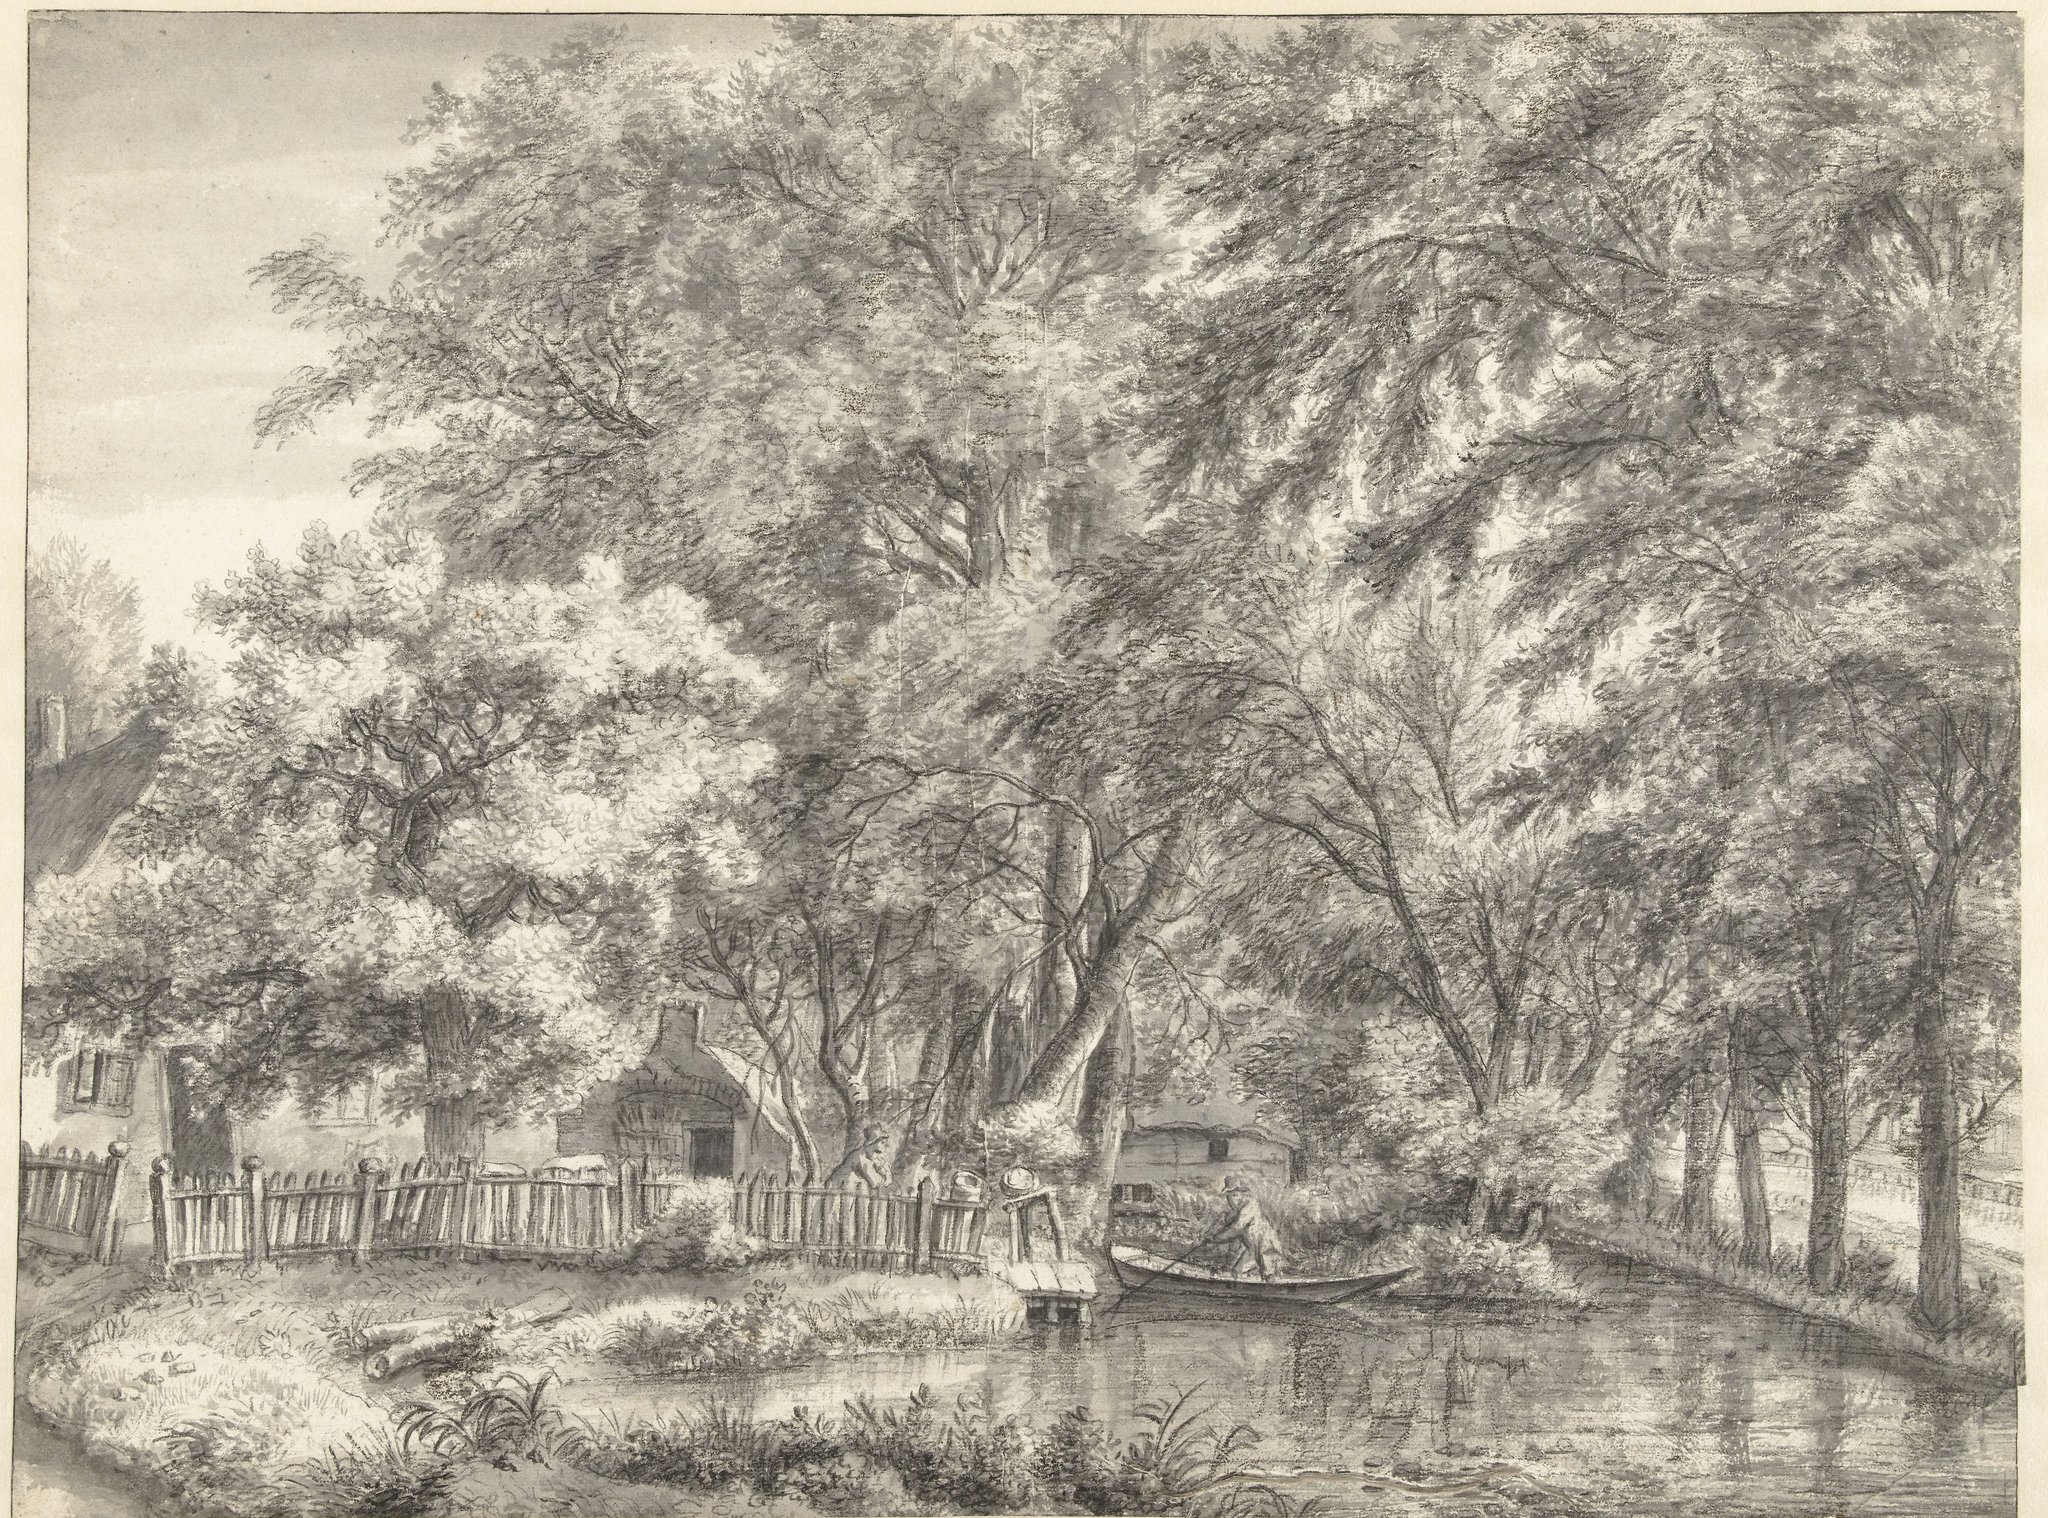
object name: drawing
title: Boerderij omgeven door hoge bomen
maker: anthonie waterloo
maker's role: draughtsman, painter, print maker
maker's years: 1609-1690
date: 1619-1690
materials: chalk, paper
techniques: brush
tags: farm or solitary house in landscape